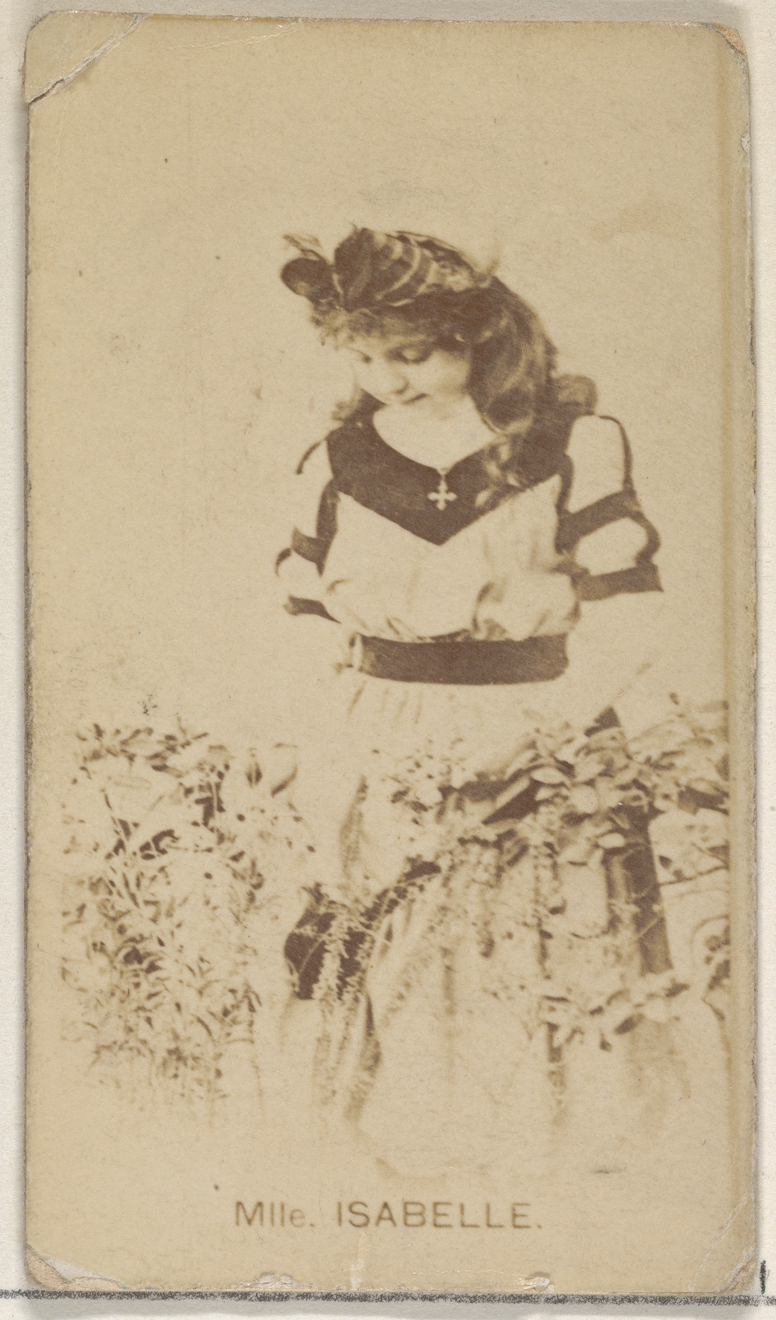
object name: photograph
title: Mlle. Isabelle, from the Actors and Actresses series (N45, Type 8) for Virginia Brights Cigarettes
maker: allen & ginter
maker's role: publisher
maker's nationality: american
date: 1888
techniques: albumen silver print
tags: girls,portraits,actresses